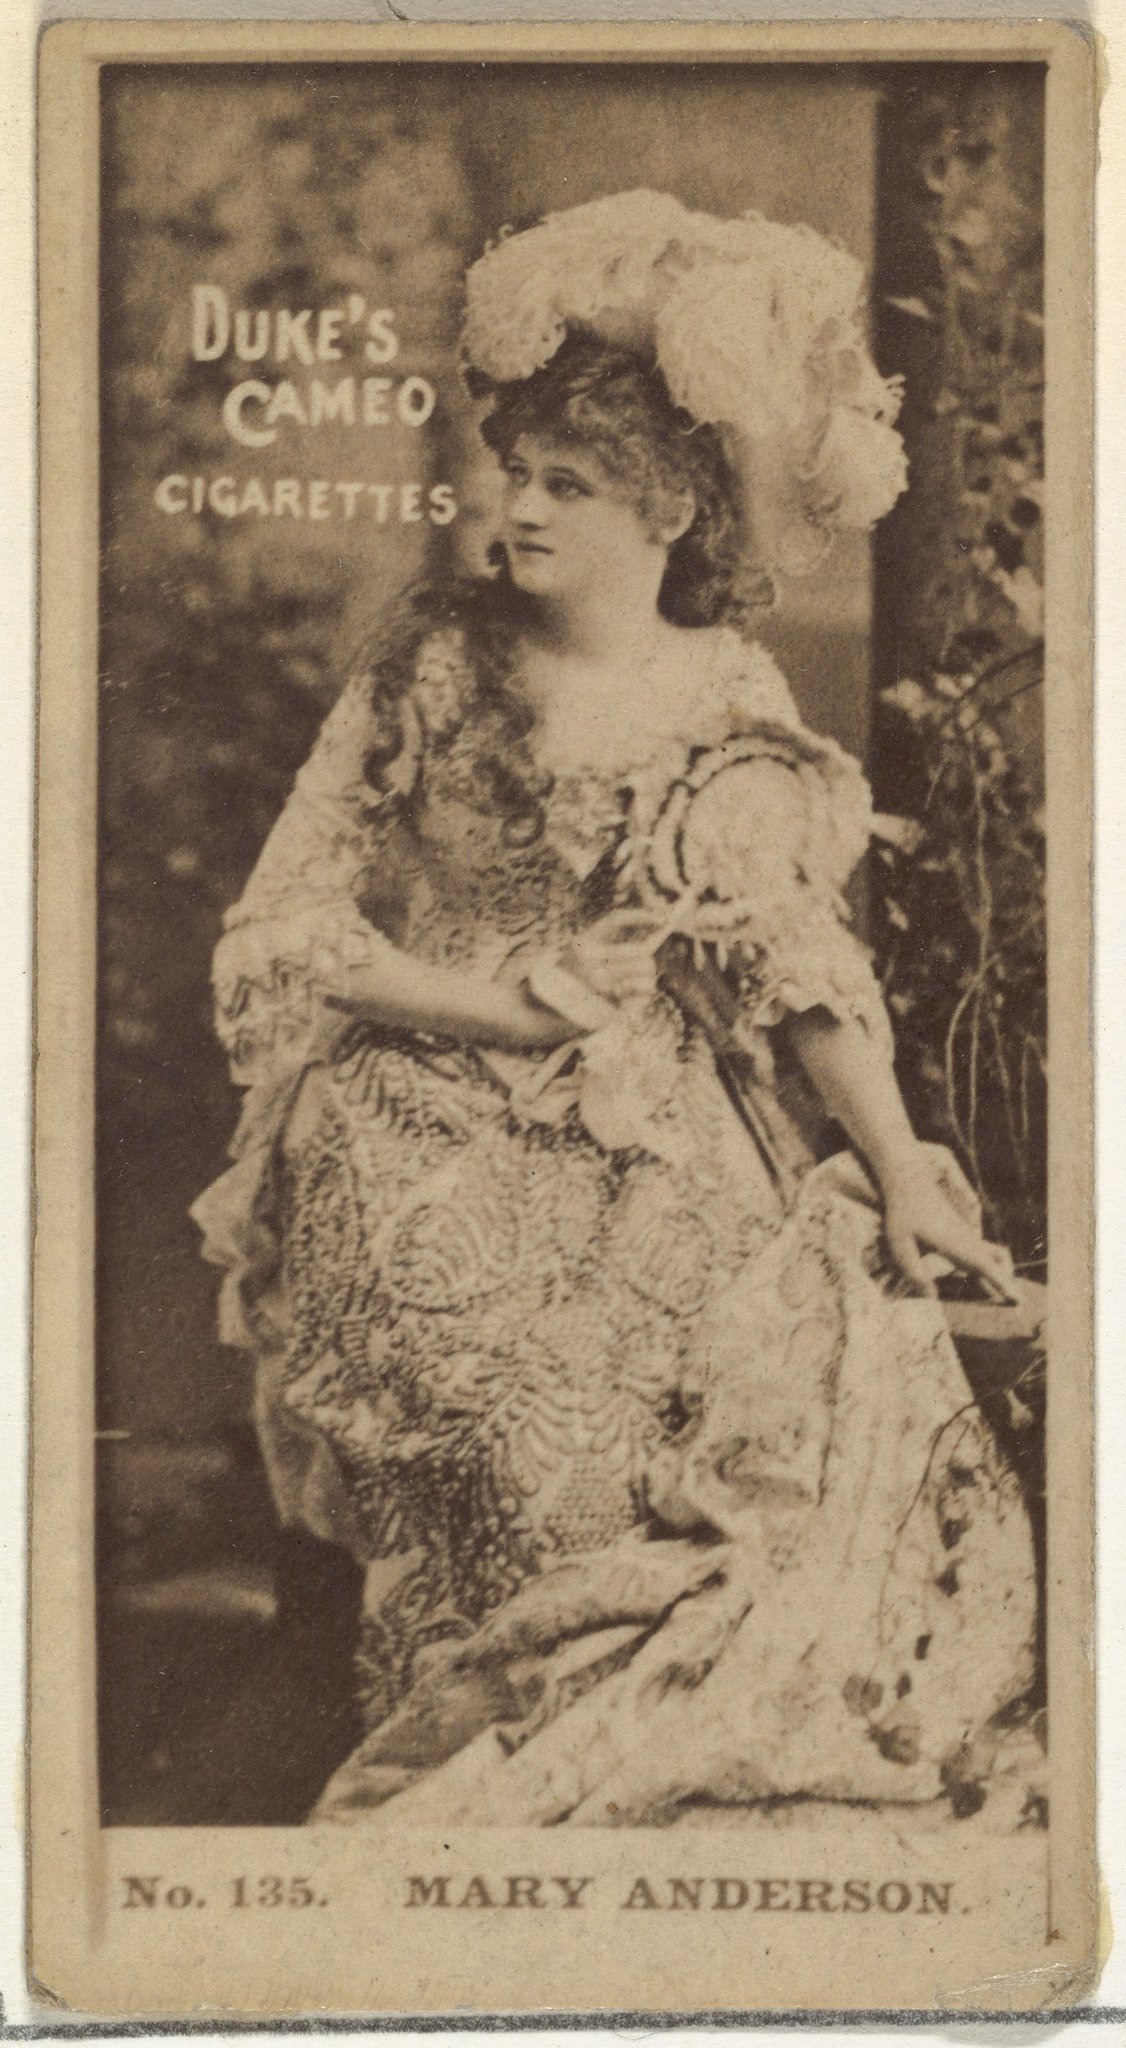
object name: photograph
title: Card Number 135, Mary Anderson, from the Actors and Actresses series (N145-4) issued by Duke Sons & Co. to promote Cameo Cigarettes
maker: w. duke, sons & co.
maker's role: publisher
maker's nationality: american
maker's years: 1870-1920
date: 1880-1889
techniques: albumen silver print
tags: portraits,women,actresses